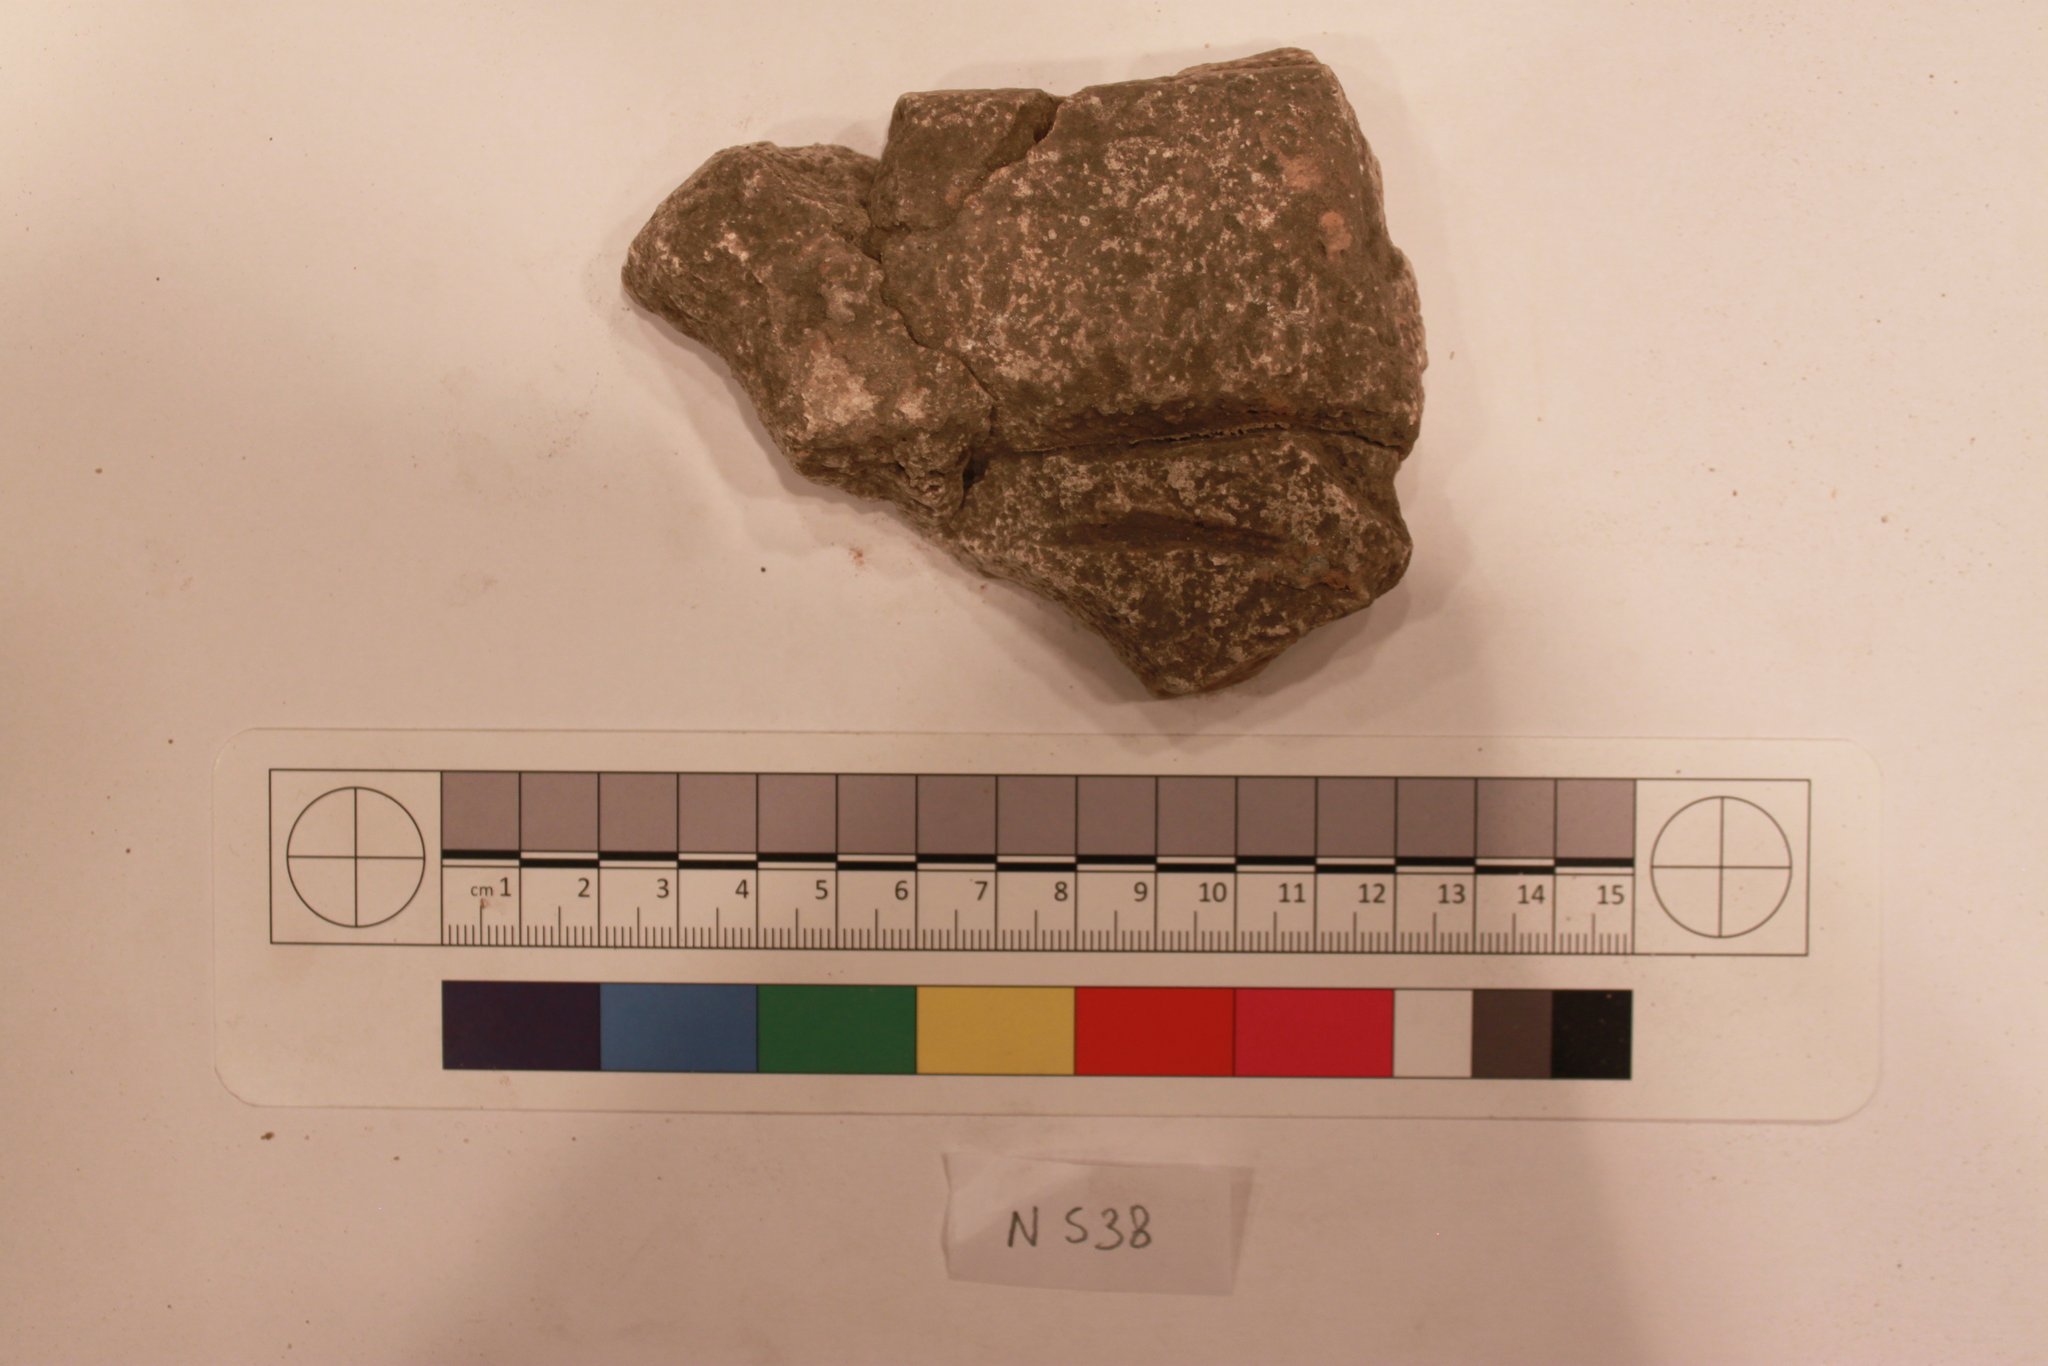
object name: fragment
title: Stucco Fragment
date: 701-1200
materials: plaster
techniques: carving, painting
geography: iran